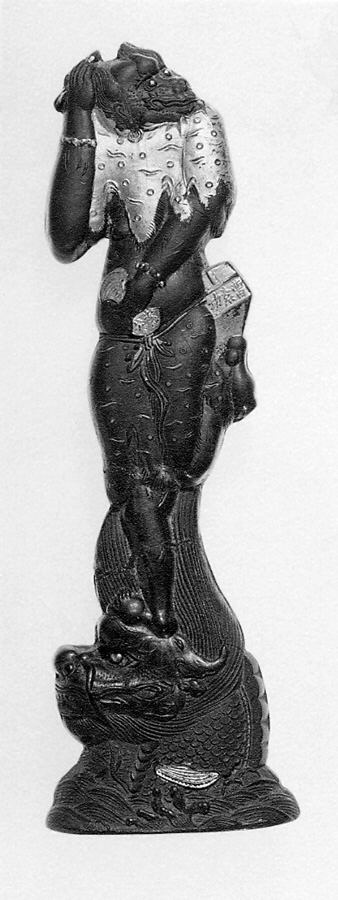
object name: ink tablet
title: Ink Tablet In Shape of a Demon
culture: chinese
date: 1662-1722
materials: ink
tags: demons